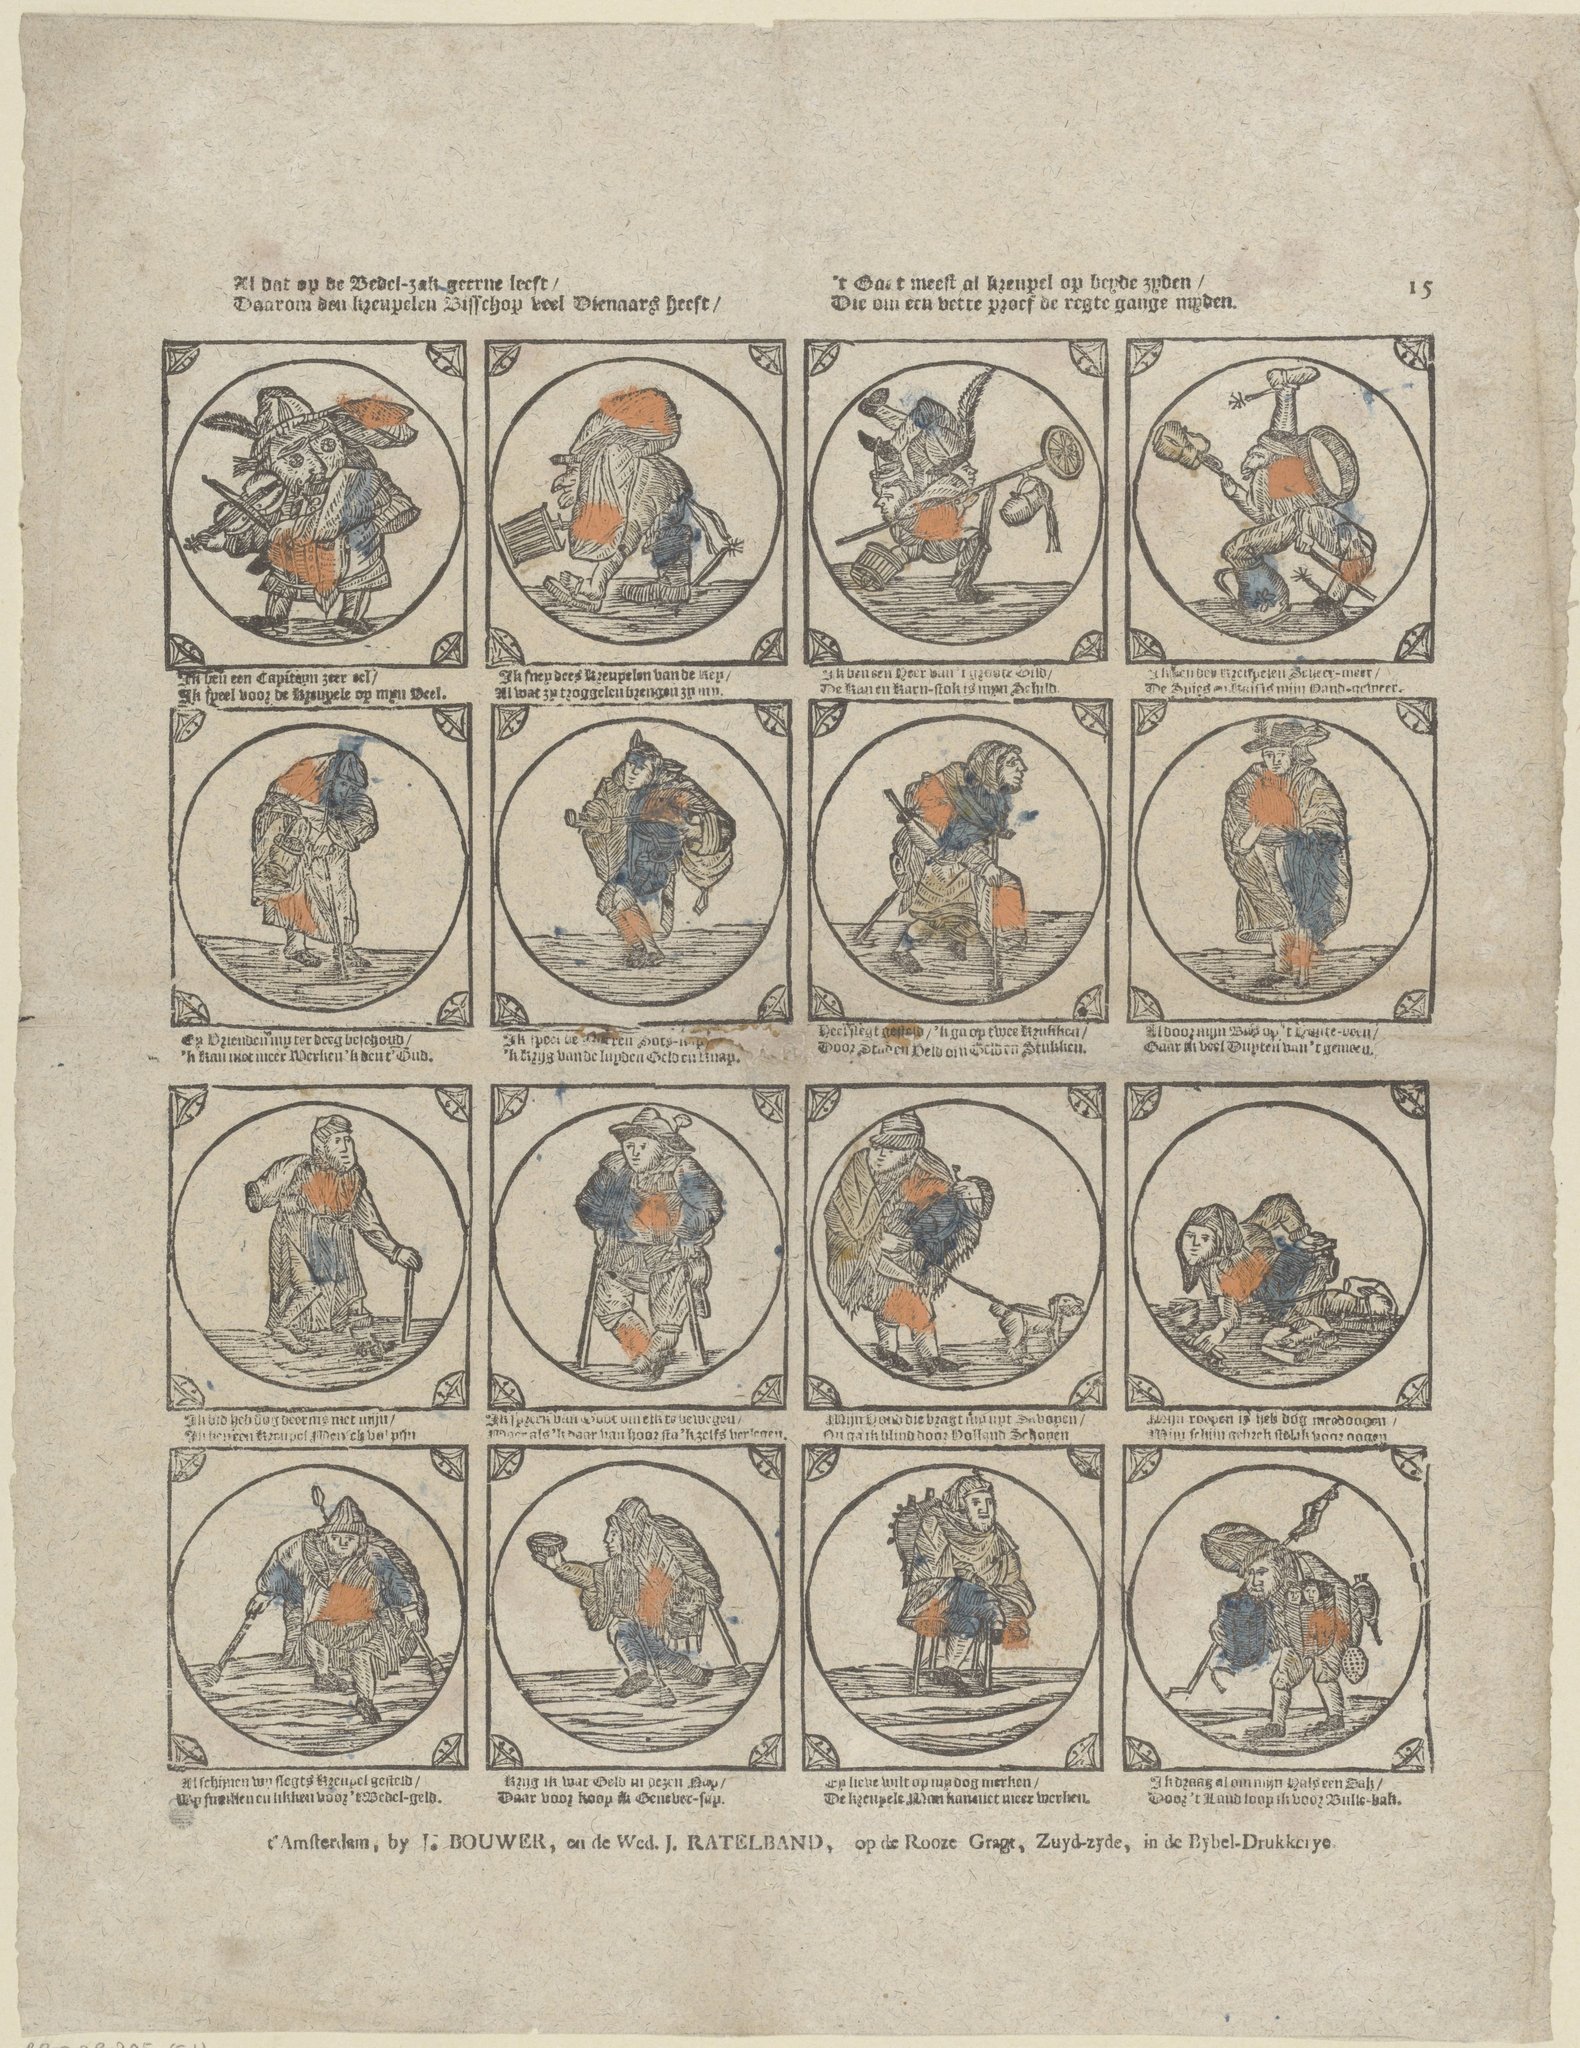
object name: popular print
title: Al dat op de bedel-zak geerne leeft / 't Gaat meest al kreupel op beyde zyden / Daarom den kreupelen bisschop veel dienaars heeft / Die om een vette proef de regte gange myden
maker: Anonymous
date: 1794-1804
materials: paper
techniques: colour, letterpress printing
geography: amsterdam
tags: person with a physical disability, beggar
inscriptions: collector's mark: Lugt 2760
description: Blad met 16 voorstellingen van bedelaars. Onder elke afbeelding een tweeregelig vers. Genummerd rechtsboven: 15. In de tijd waarin deze prent ontstond was 'kreupel' een generiek woord om een lichamelijke beperking aan het onderlichaam te beschrijven. Deze prent is bedoeld als sociale satire.